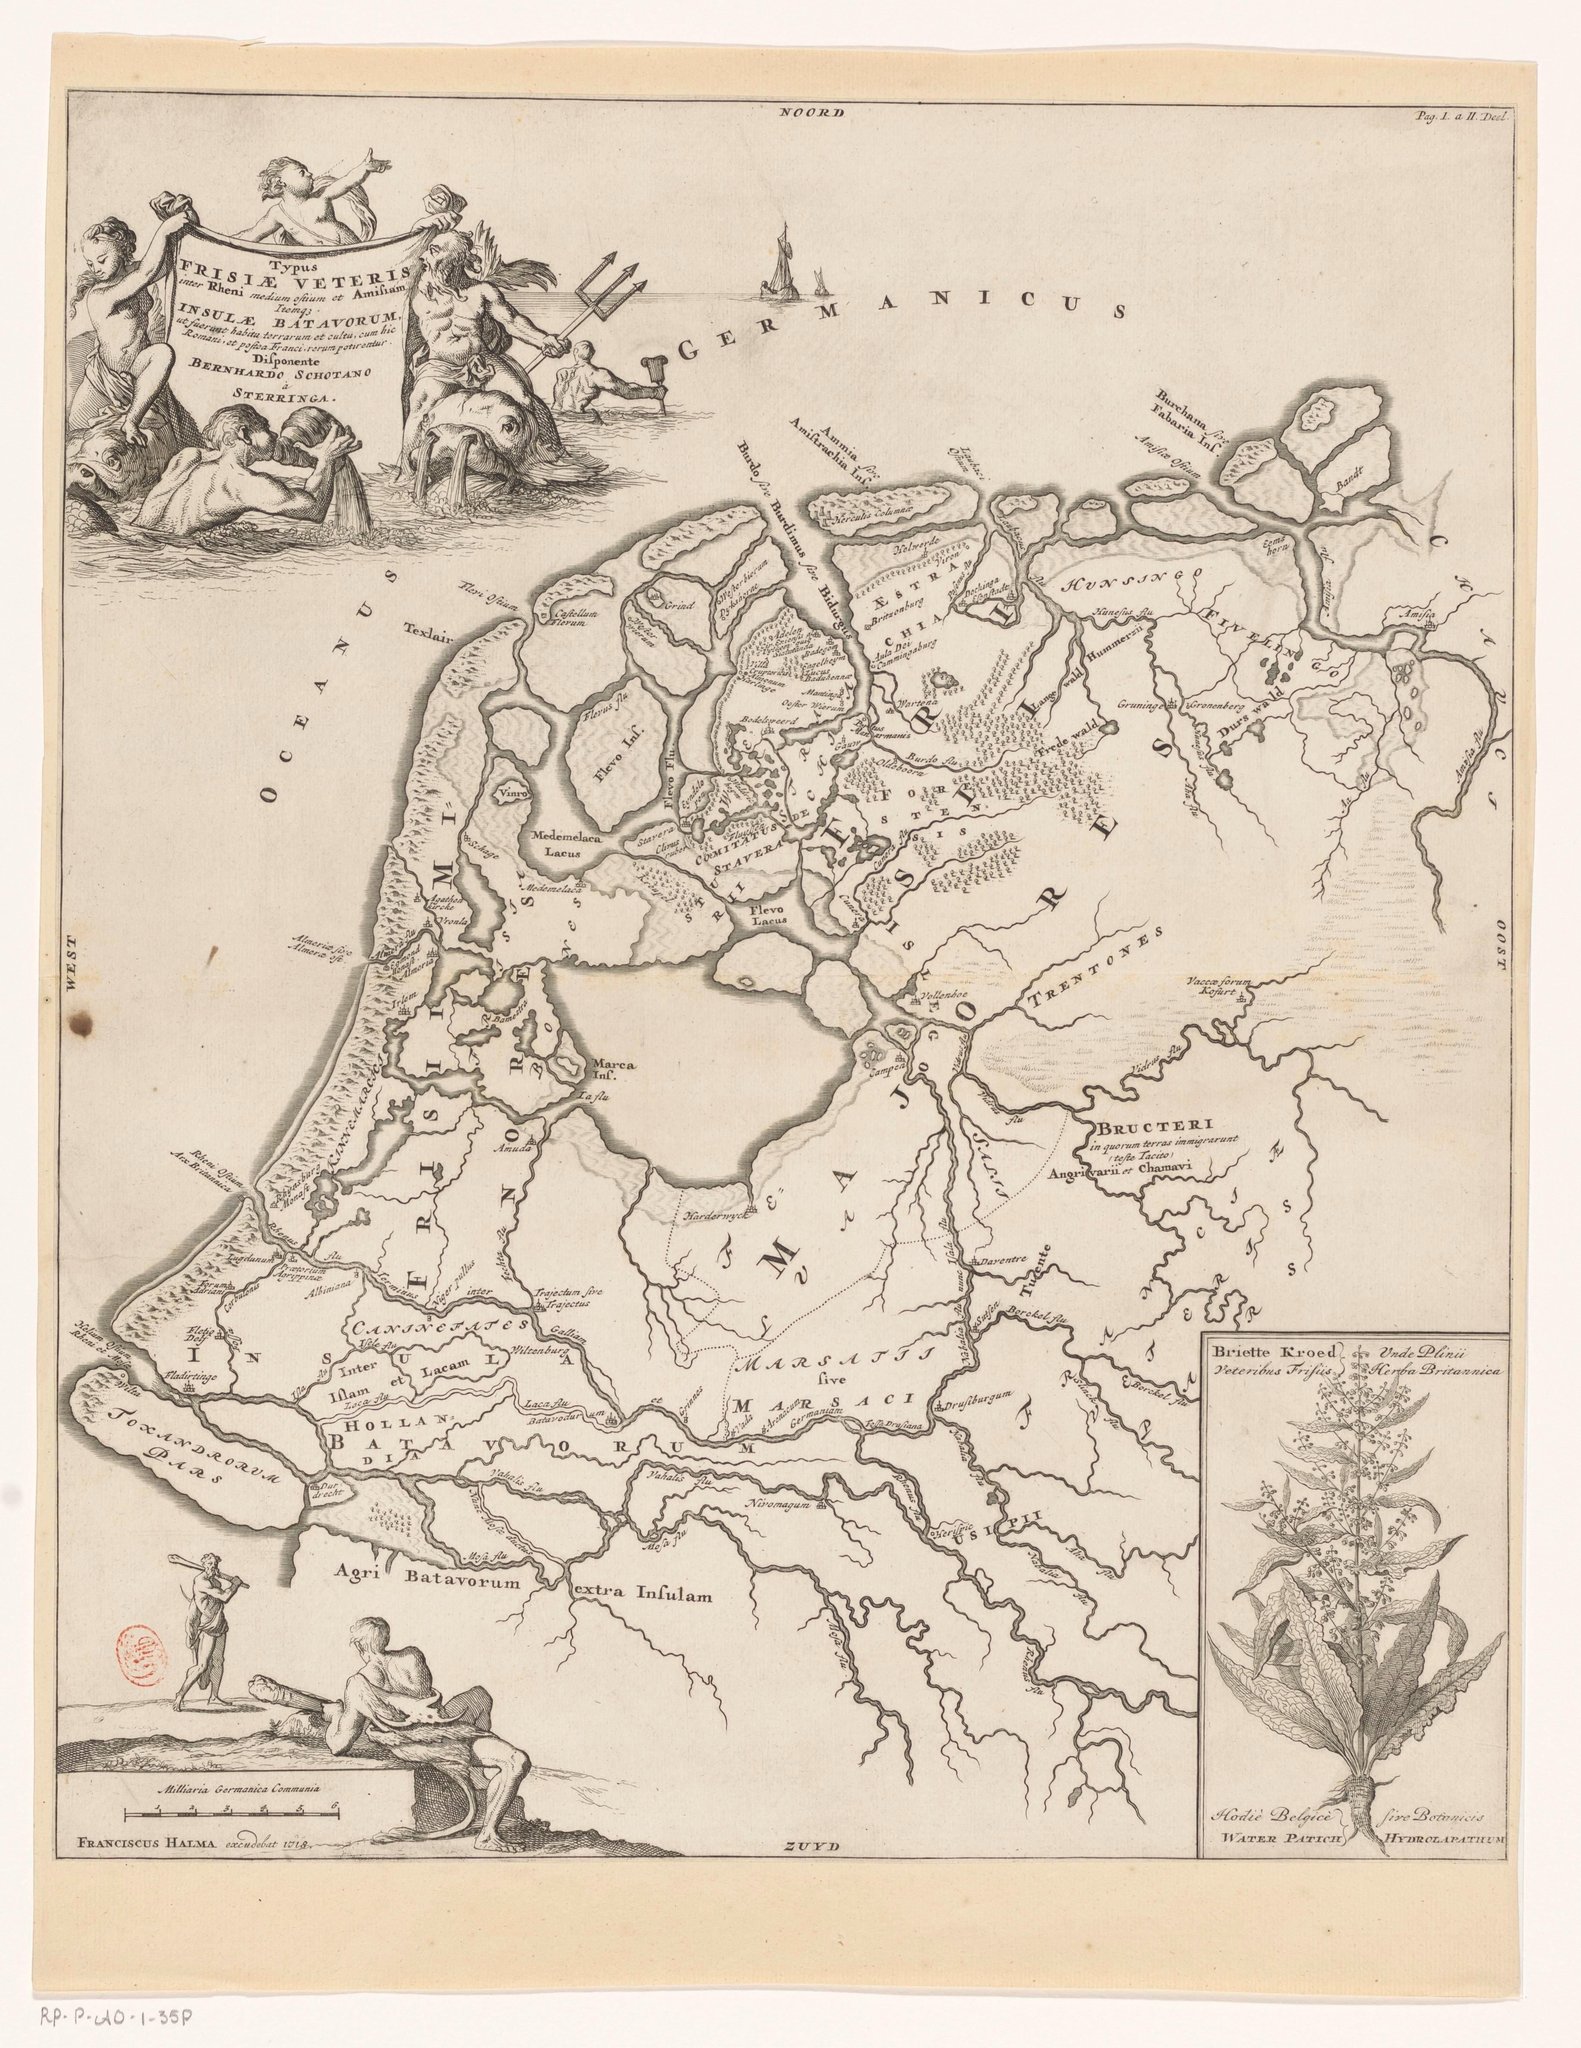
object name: print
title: Typus Frisiae veteris (...) insulae Batavorum (...)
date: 1697-1700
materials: paper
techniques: engraving, etching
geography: leeuwarden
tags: (story of) neptune (poseidon), triton(s), maps of separate countries or regions, netherlands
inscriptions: collector's mark: Lugt 195, collector's mark: Lugt 2228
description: Maakt deel uit van 16 kaarten van het land van de Bataven en de Friezen eerst vervaardigd voor en opgenomen in Alting, Menso. Descriptio, secundum antiquos, agri Batavi & Frisii. 2 delen. Amsterdam: Henricus Wetstein, 1697-1700. Hergebruikt in Halma, François. Tooneel der Vereenigde Nederlanden, en onderhorige landschappen (...). 2 delen Leeuwarden: Hendrik Halma, 1725, 2. Een deel van deze kaarten, waaronder dit exemplaar, is ook gebruikt in Schotanus à Sterringa, Bernardus. Uitbeelding der Heerlijkheit Friesland. Zoo int algemeen, als in haare XXX bijzondere grietenijen (...). Leeuwarden: François Halma, 1718. Deze kaart is gebruikt in Halma's Tooneel der Vereenigde Nederlanden (1725) en is waarschijnlijk te vinden in deel 2, p. 1a.